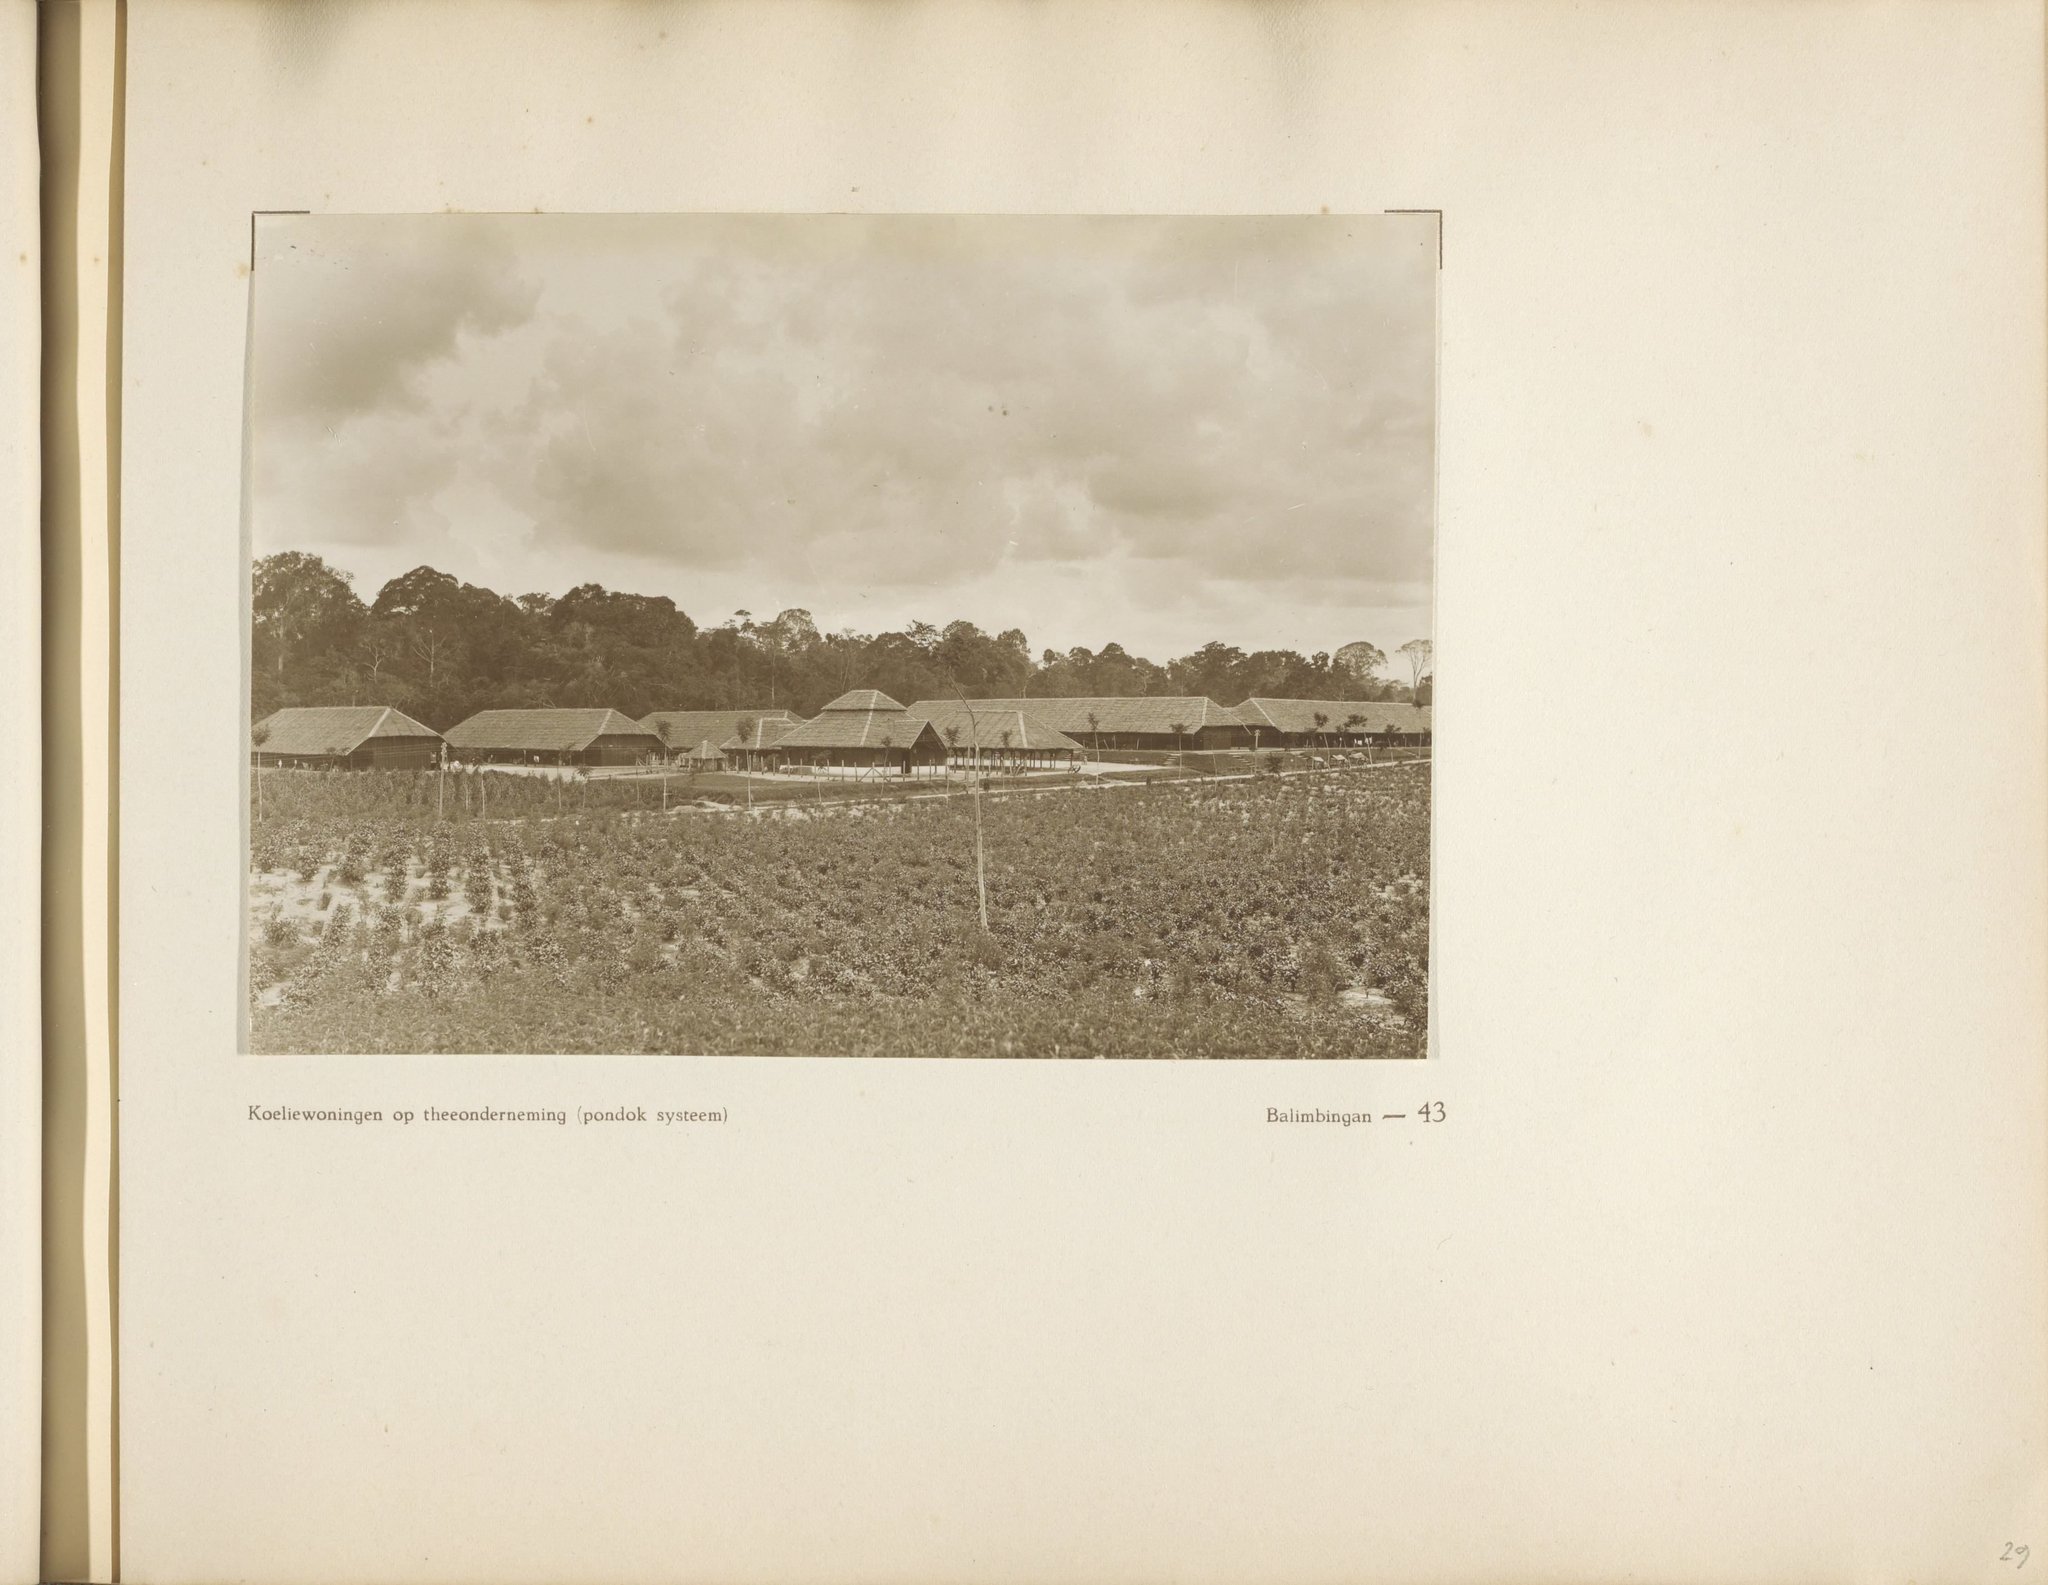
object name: photograph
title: Pagina 43 van fotoboek van de Algemeene Vereeniging van Rubberplanters ter Oostkust van Sumatra (A.V.R.O.S.)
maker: j.w. meyster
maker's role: fotograaf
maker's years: 1887-1945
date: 1924-1925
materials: paper, photographic support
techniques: printing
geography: sumatra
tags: plantation, (non-fruit) products of plants or trees: rubber, working class, labourers, barracks, sumatra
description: Boekpagina met een foto van woningen van contractarbeiders op een theeonderneming te Balimbingan. Onderdeel van een fotoboek van de Algemeene Vereeniging van Rubberplanters ter Oostkust van Sumatra (A.V.R.O.S.).